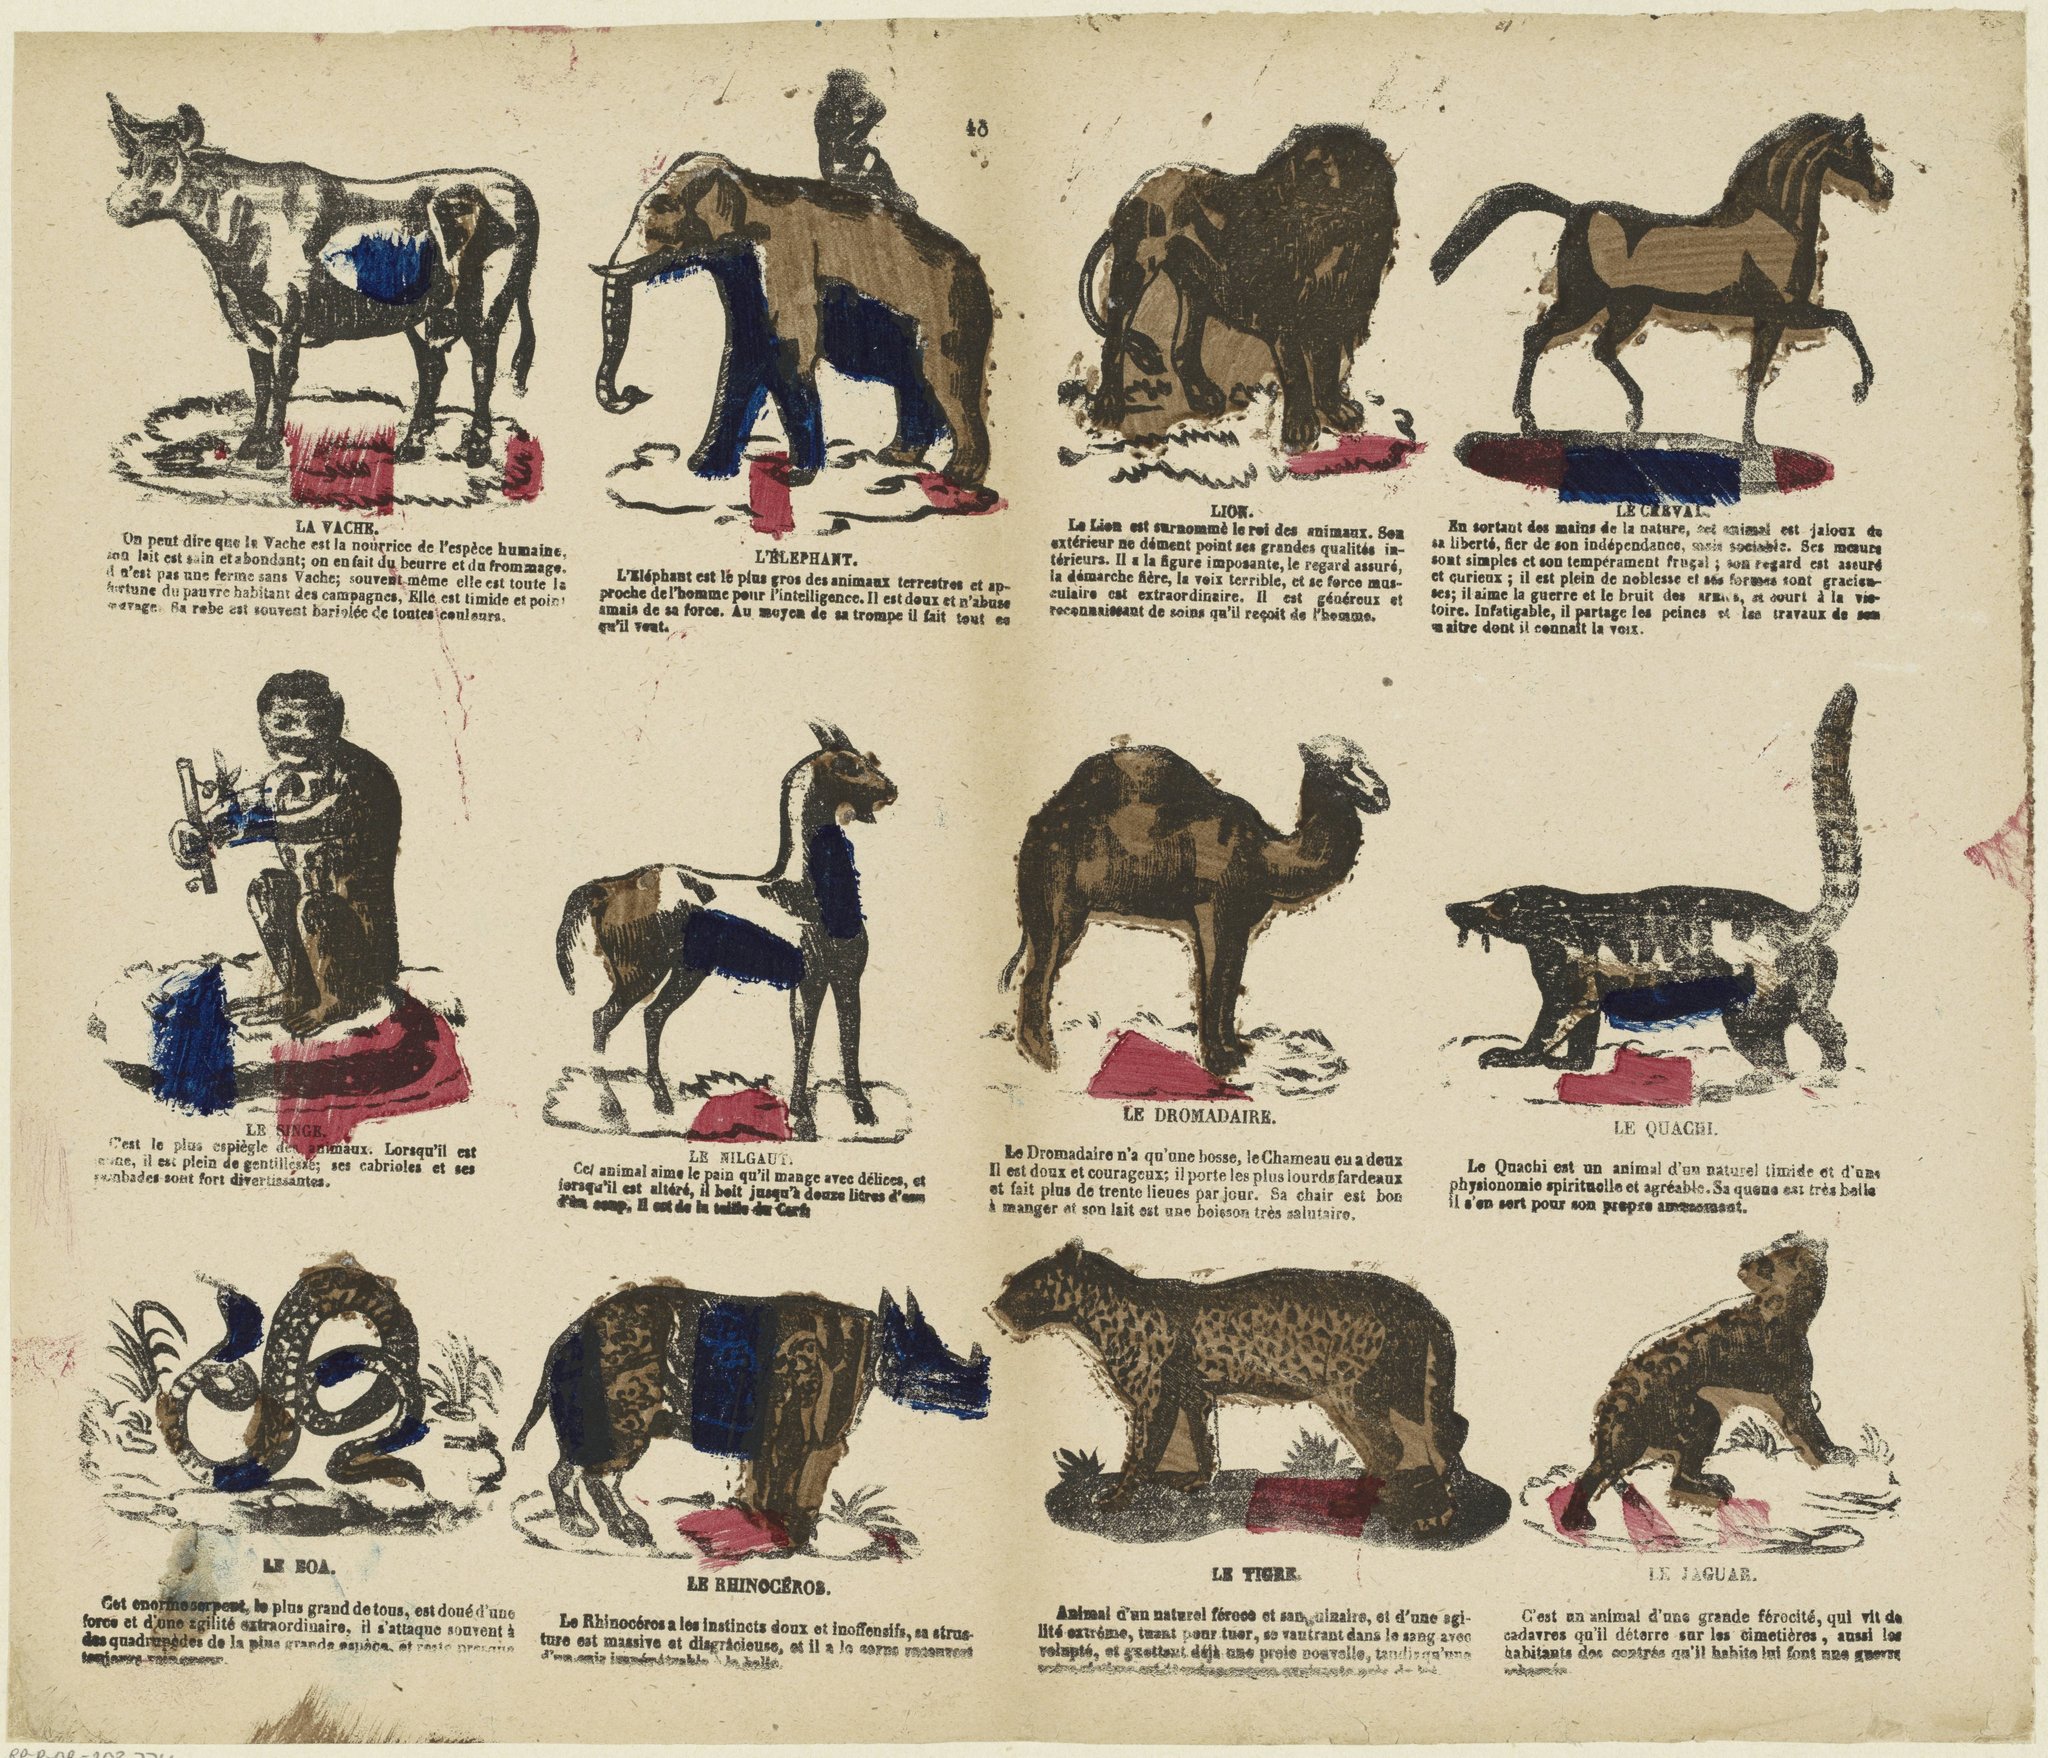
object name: popular print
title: Dieren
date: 1827-1894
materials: paper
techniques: colour, letterpress printing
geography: schaarbeek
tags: cow, hoofed animals: dromedary, animals, beasts of prey, predatory animals: lion, trunked animals: elephant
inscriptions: collector's mark: Lugt 2760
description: Blad met 12 voorstellingen van dieren, zoals een koe, een olifant, een leeuw en een dromedaris. Onder elke afbeelding een onderschrift in het Frans. Genummerd midden boven: 48.